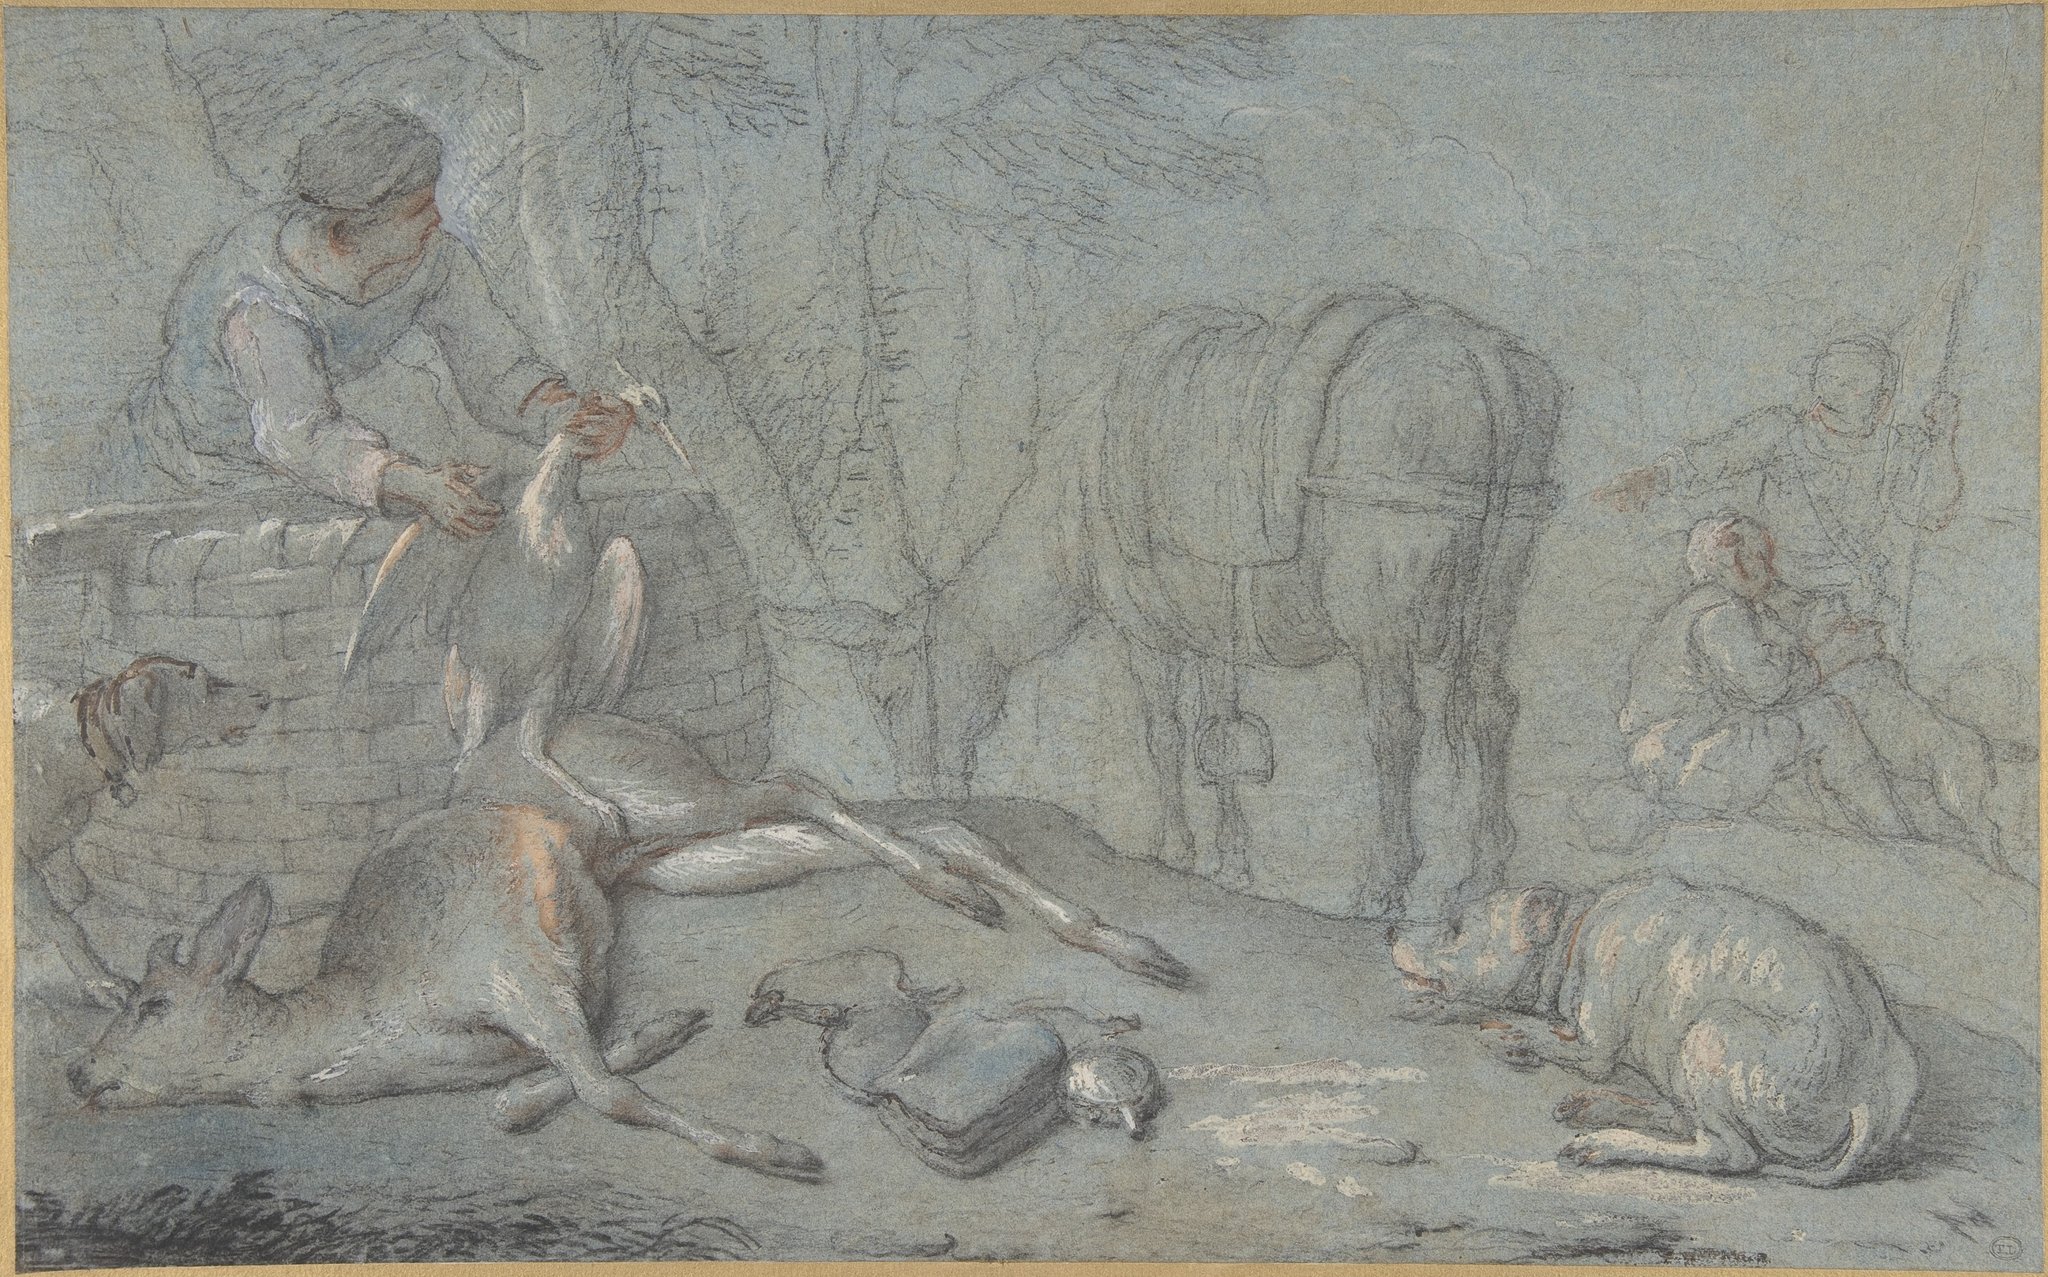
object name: drawing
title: Hunters with Dead Game in a Landscape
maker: giovanni agostino cassana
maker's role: artist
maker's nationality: italian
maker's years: 1665-1720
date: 1600-1800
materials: chalk, gouache, ink, paper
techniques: brush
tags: birds,men,dogs,horses,trees